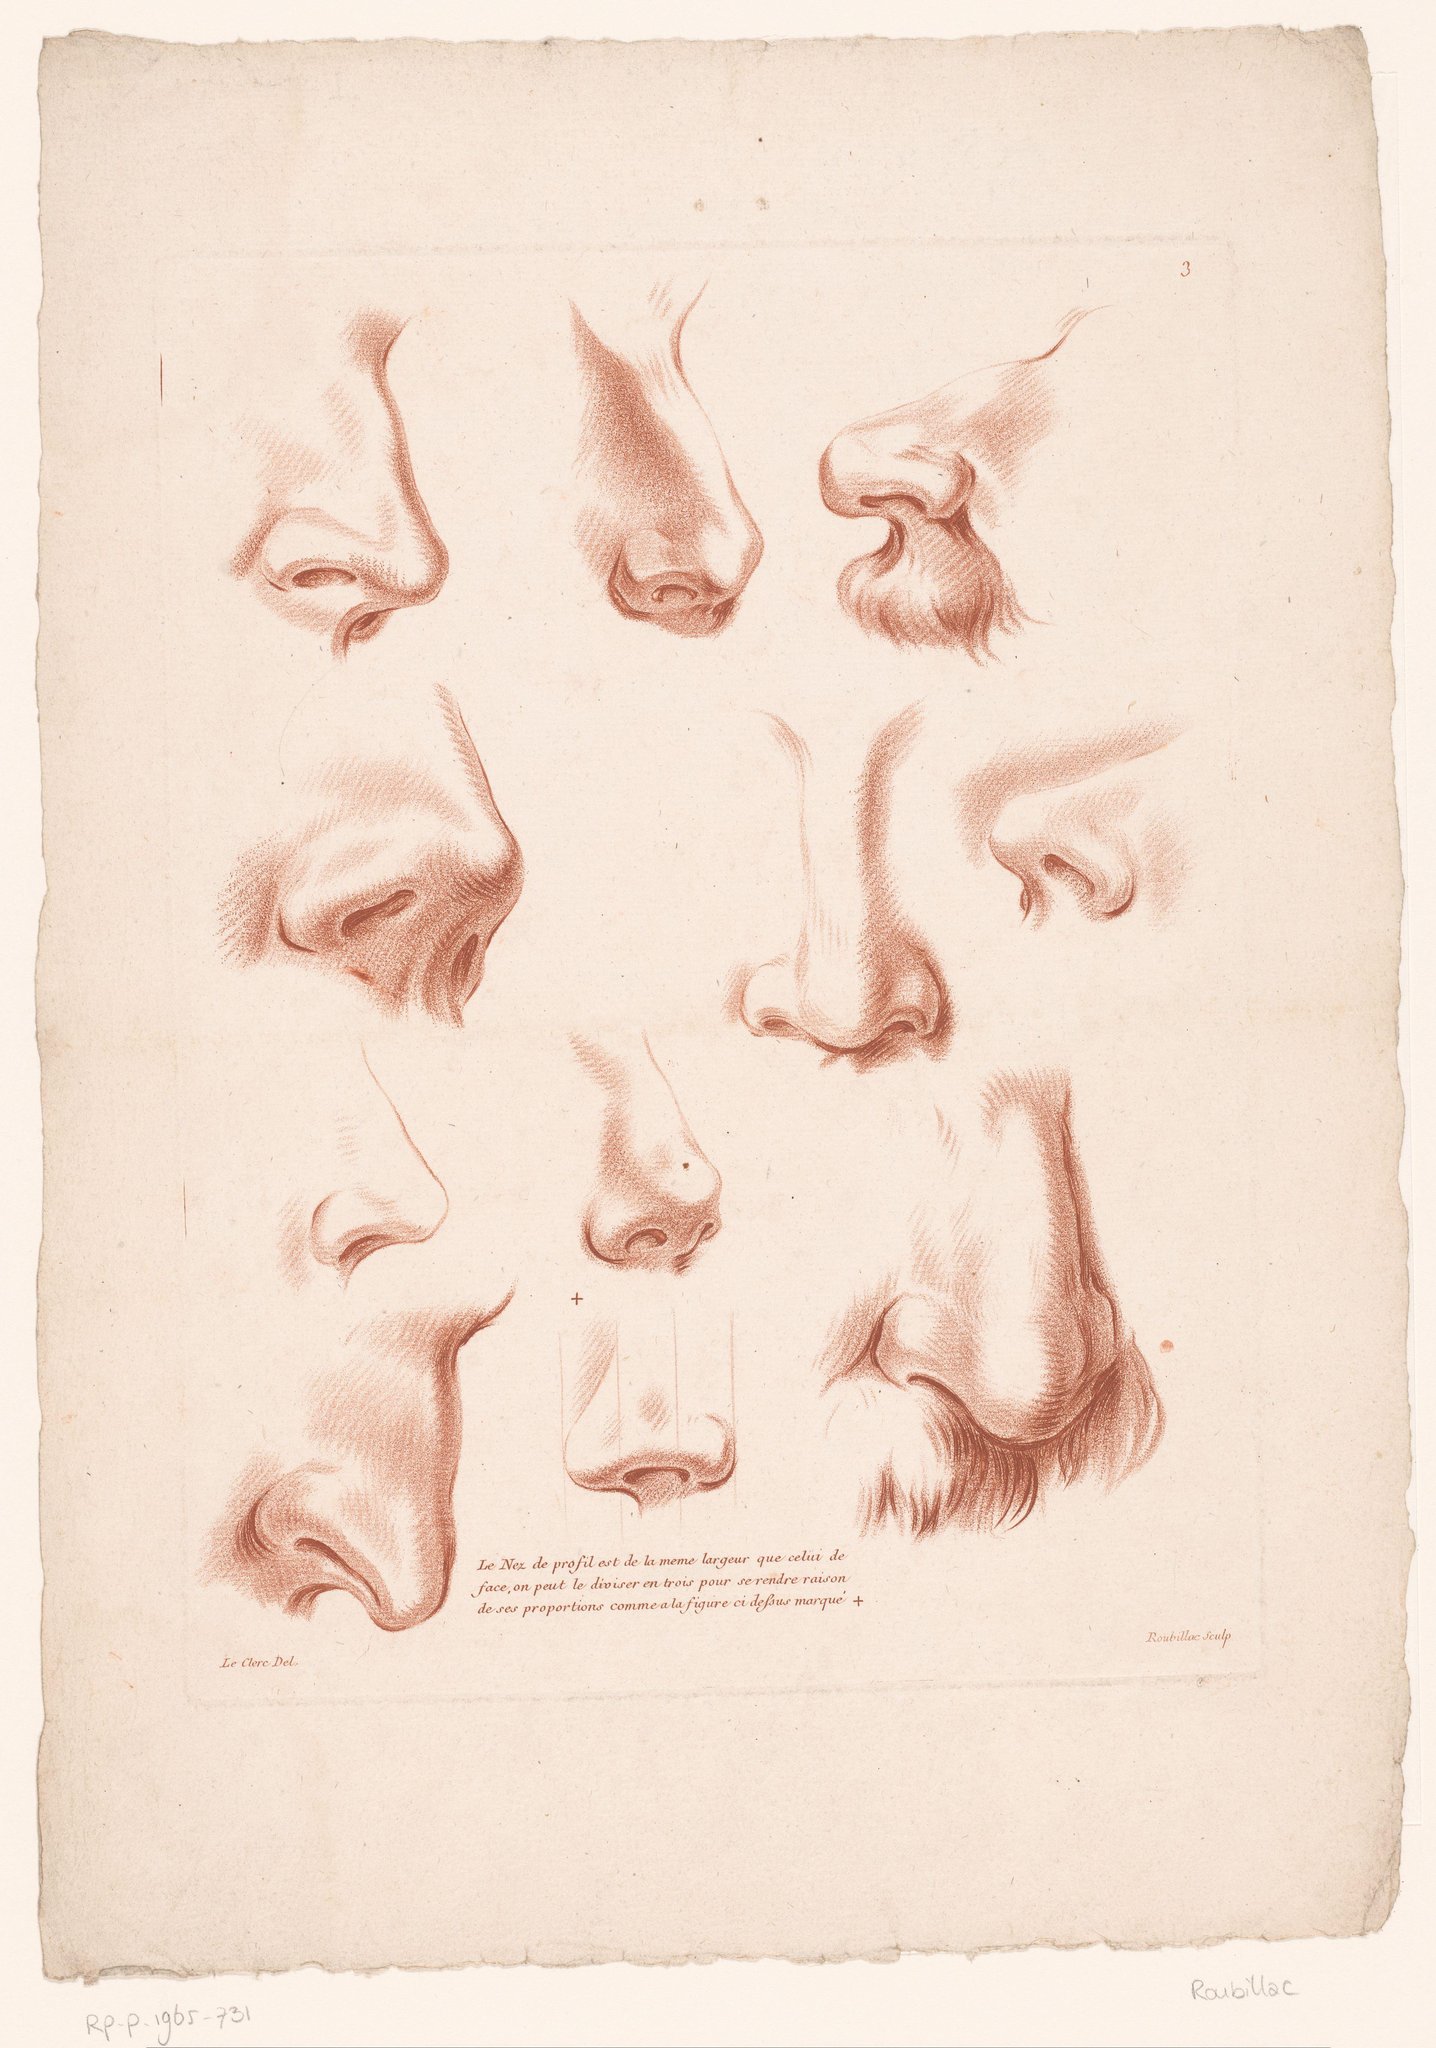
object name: print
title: Ier Cahier de Principes du Dessin d'après Nature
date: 1784-1796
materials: paper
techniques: printmaking, etching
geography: paris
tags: drawing, sketch, parts of the face: nose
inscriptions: collector's mark: Lugt 2228